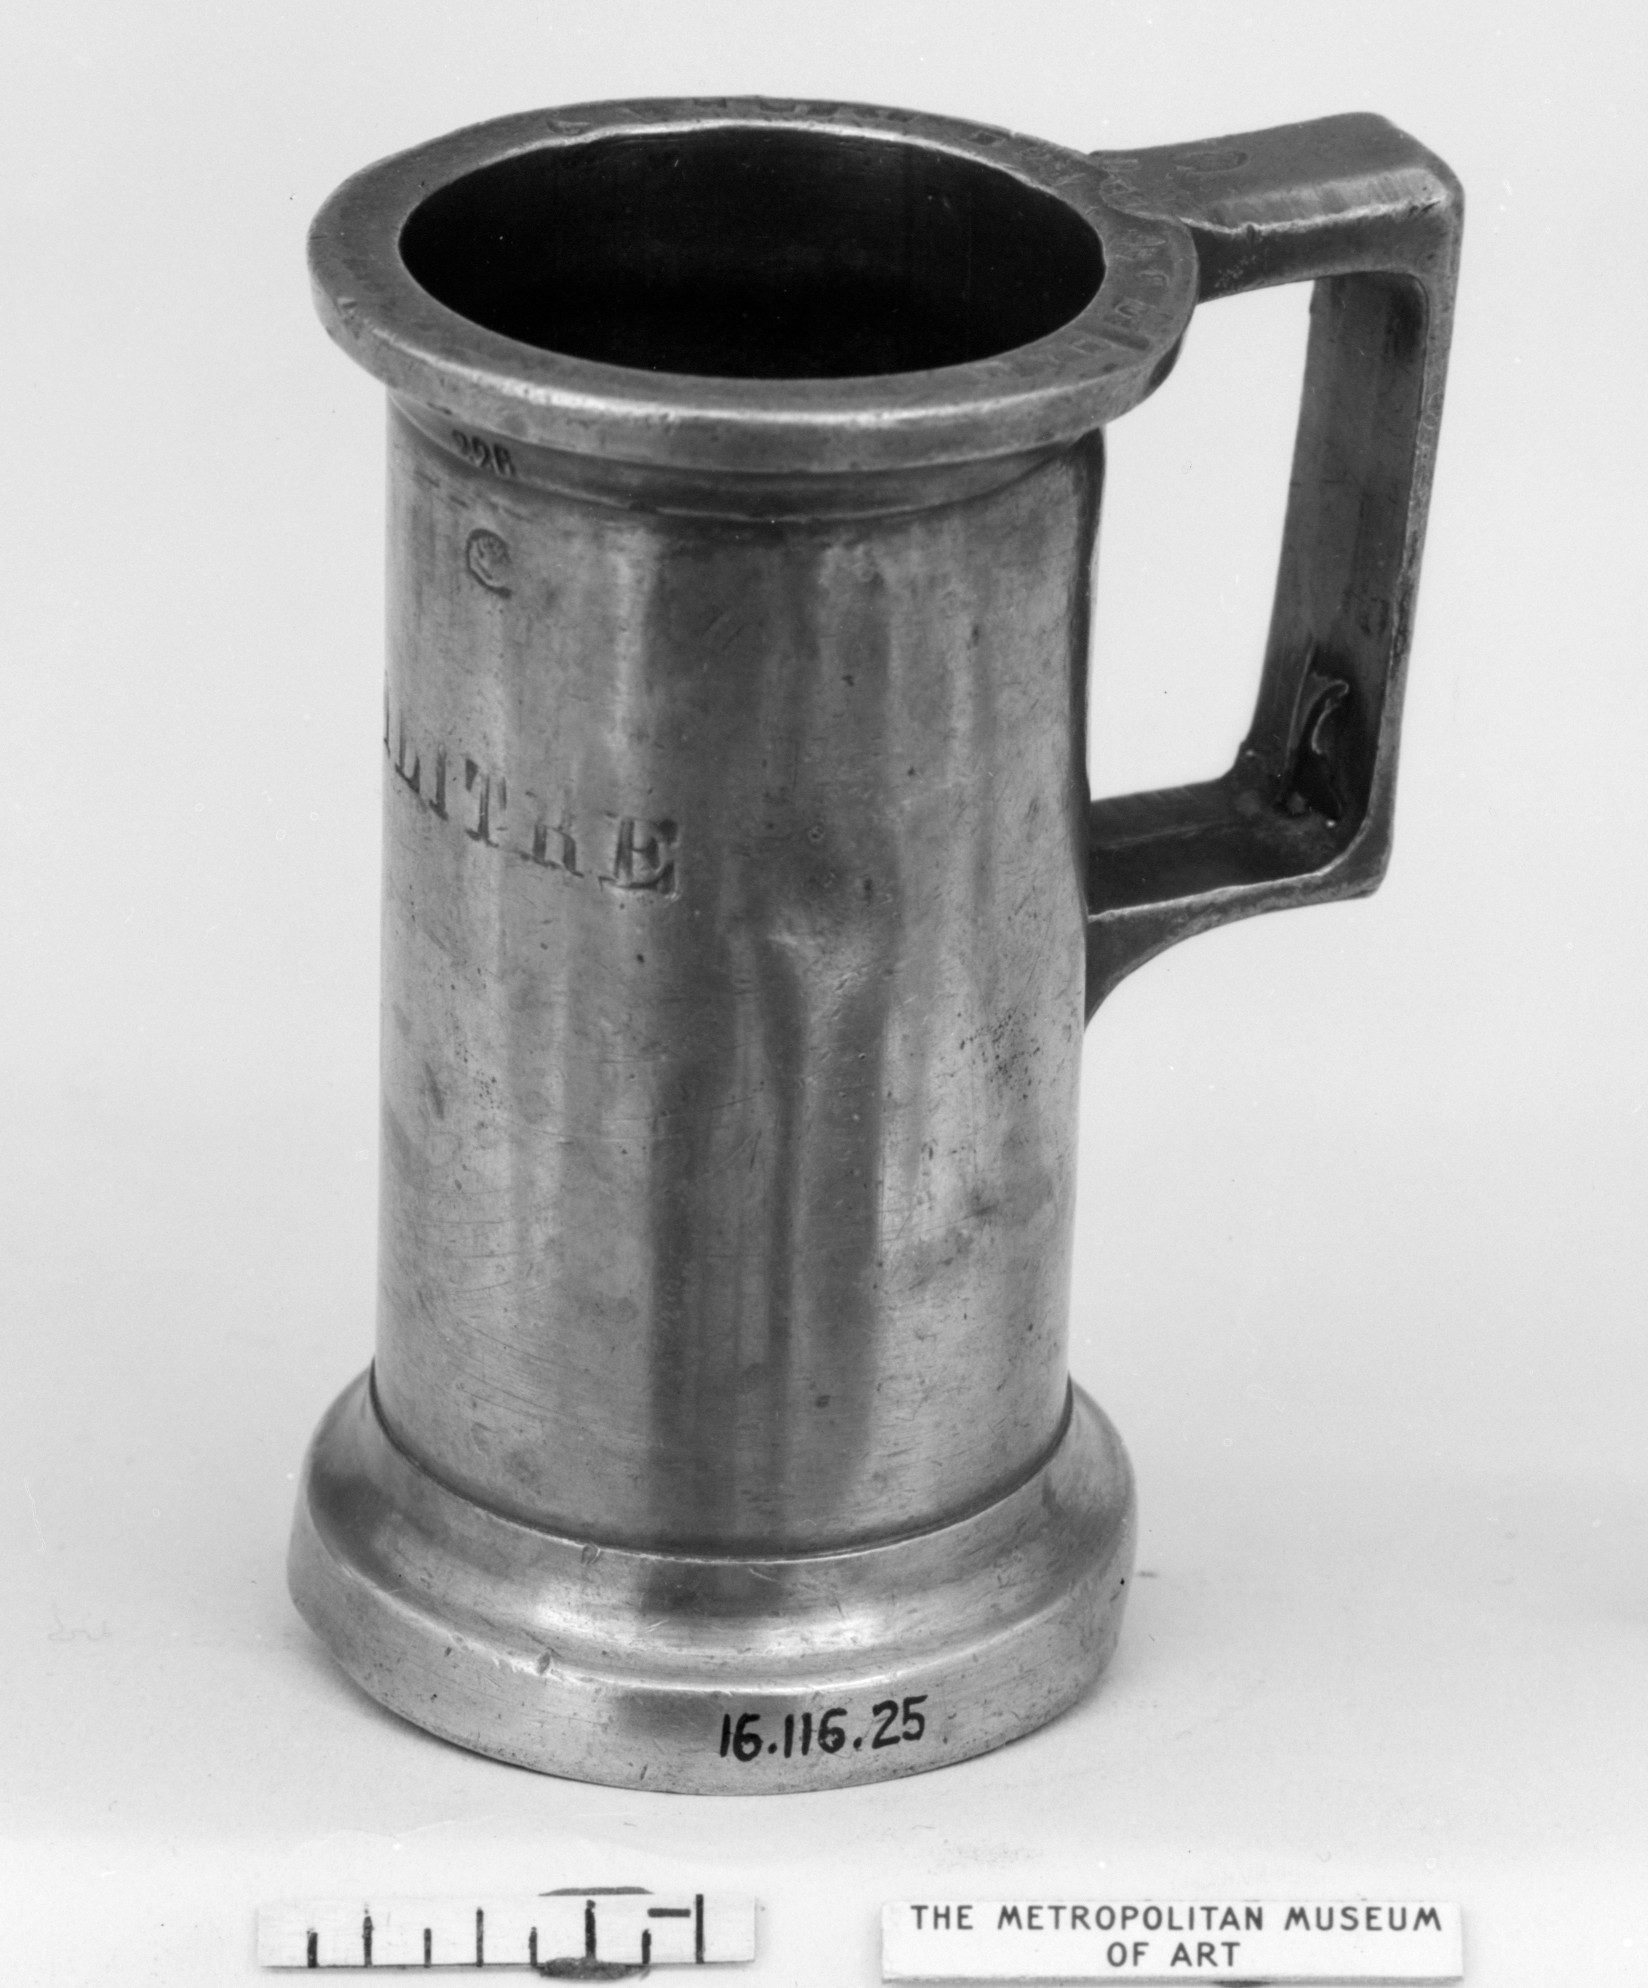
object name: measure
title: Measure (one of a set of seven)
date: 1801-1900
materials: pewter